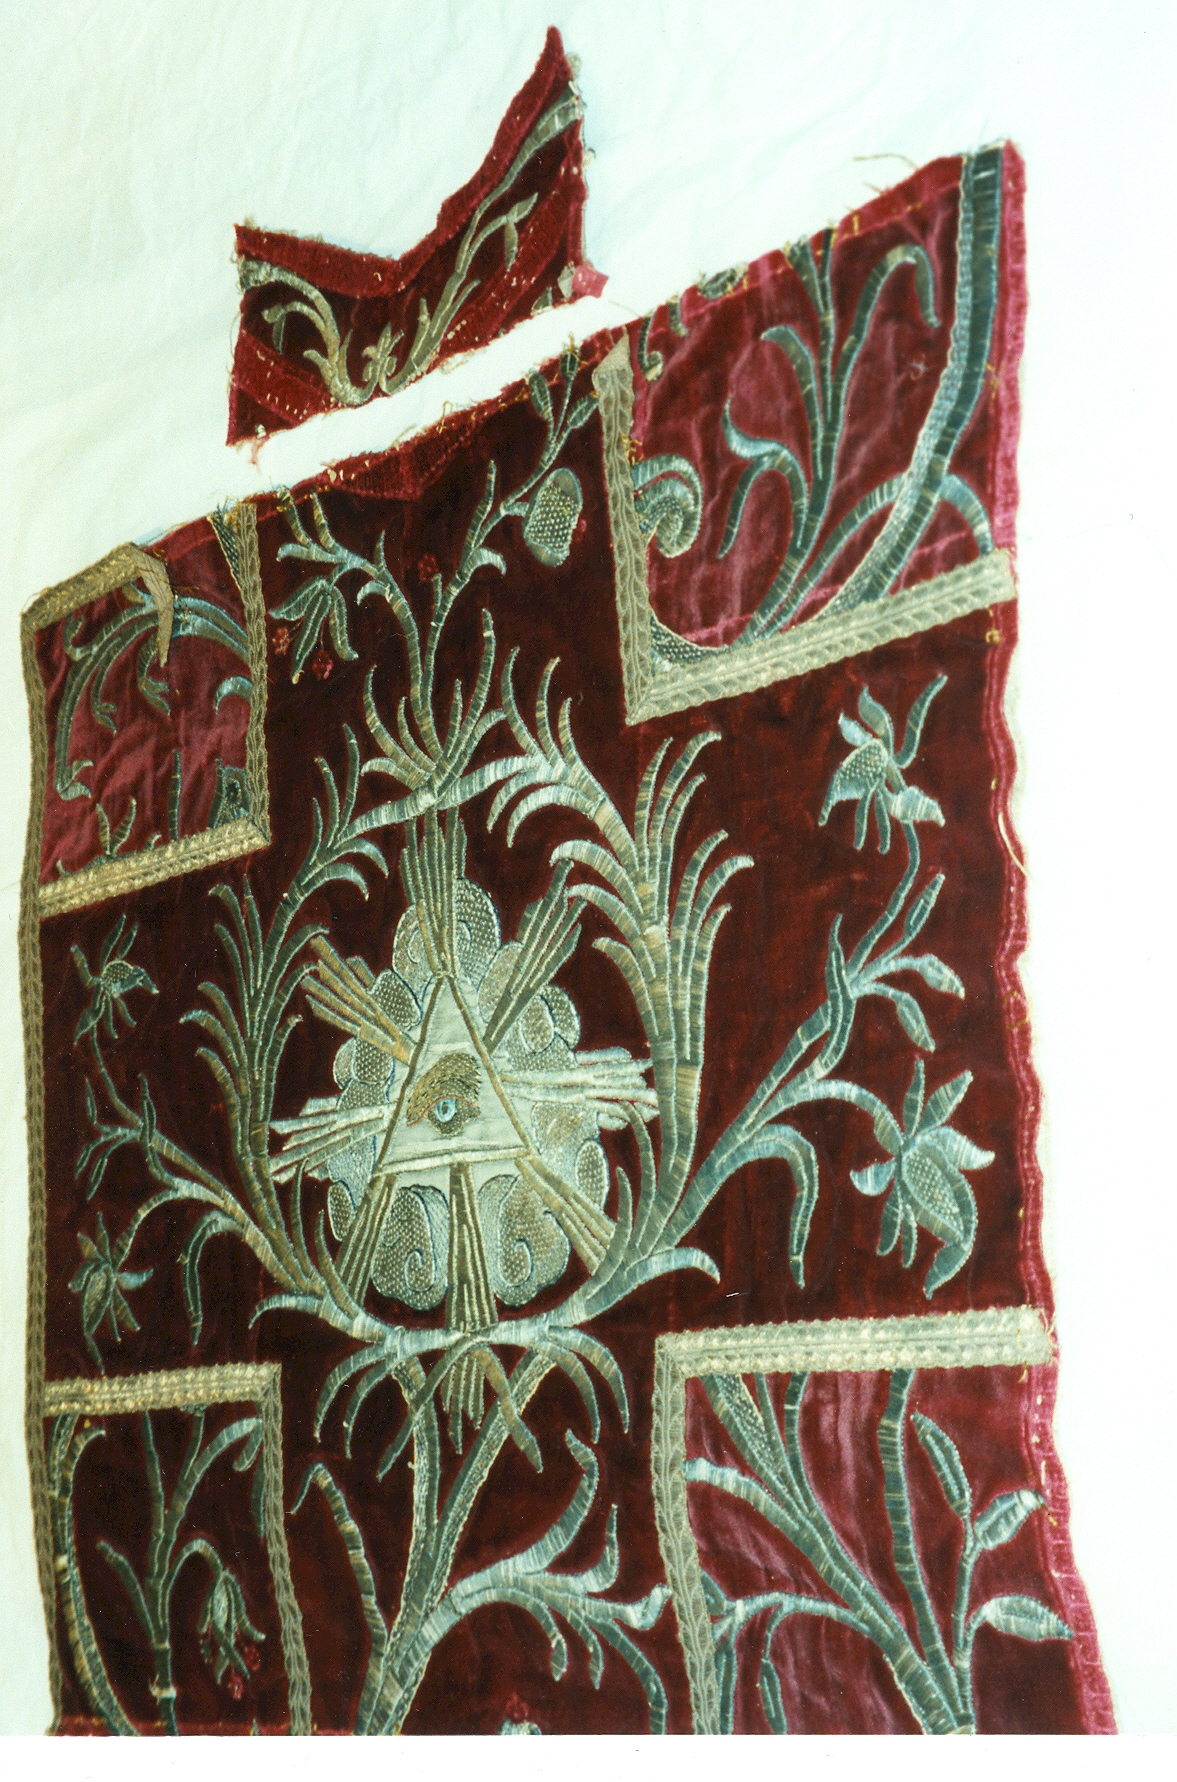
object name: chasuble fragment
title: A: Fragments of a chasuble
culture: italian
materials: linen, metal, silk